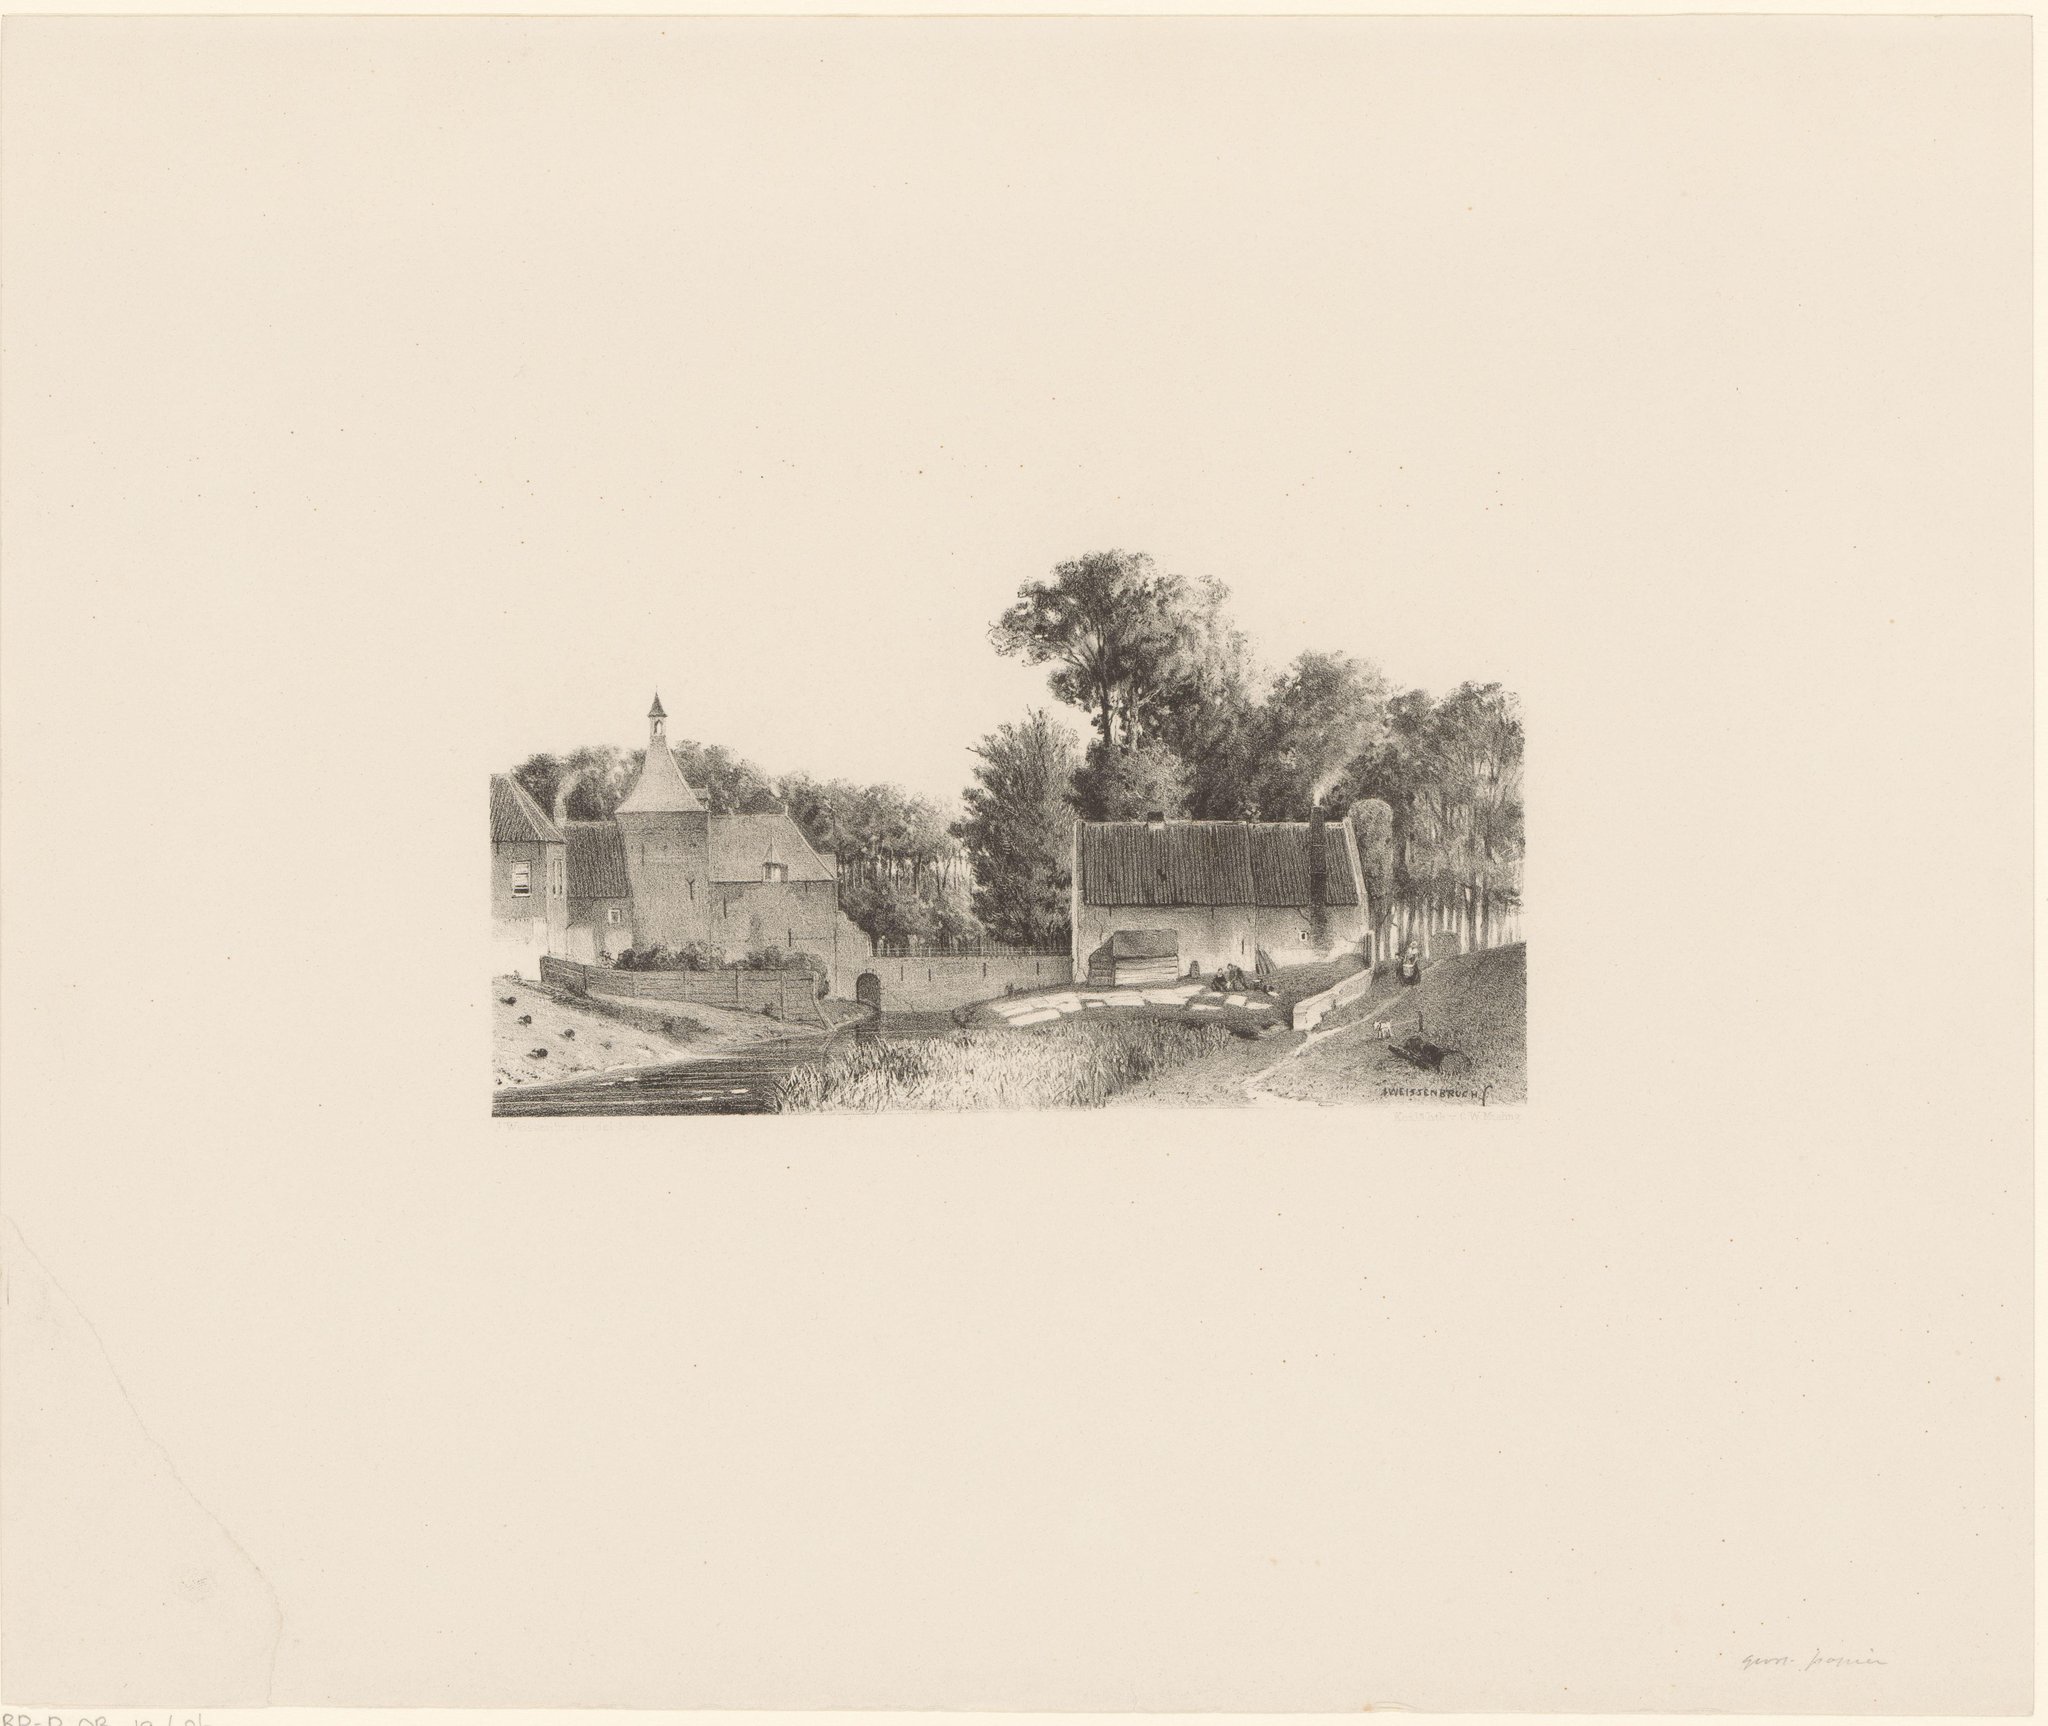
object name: print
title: Gezicht op een kasteel en het bleken van de was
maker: jan weissenbruch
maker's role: painter, print maker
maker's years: 1822-1880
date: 1847-1865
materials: paper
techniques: lithograph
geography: the hague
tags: castle, bleaching (laundering)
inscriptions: collector's mark: Lugt 2228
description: Landschap met links een kasteel. Rechts wordt op het veld wordt de was gebleekt.